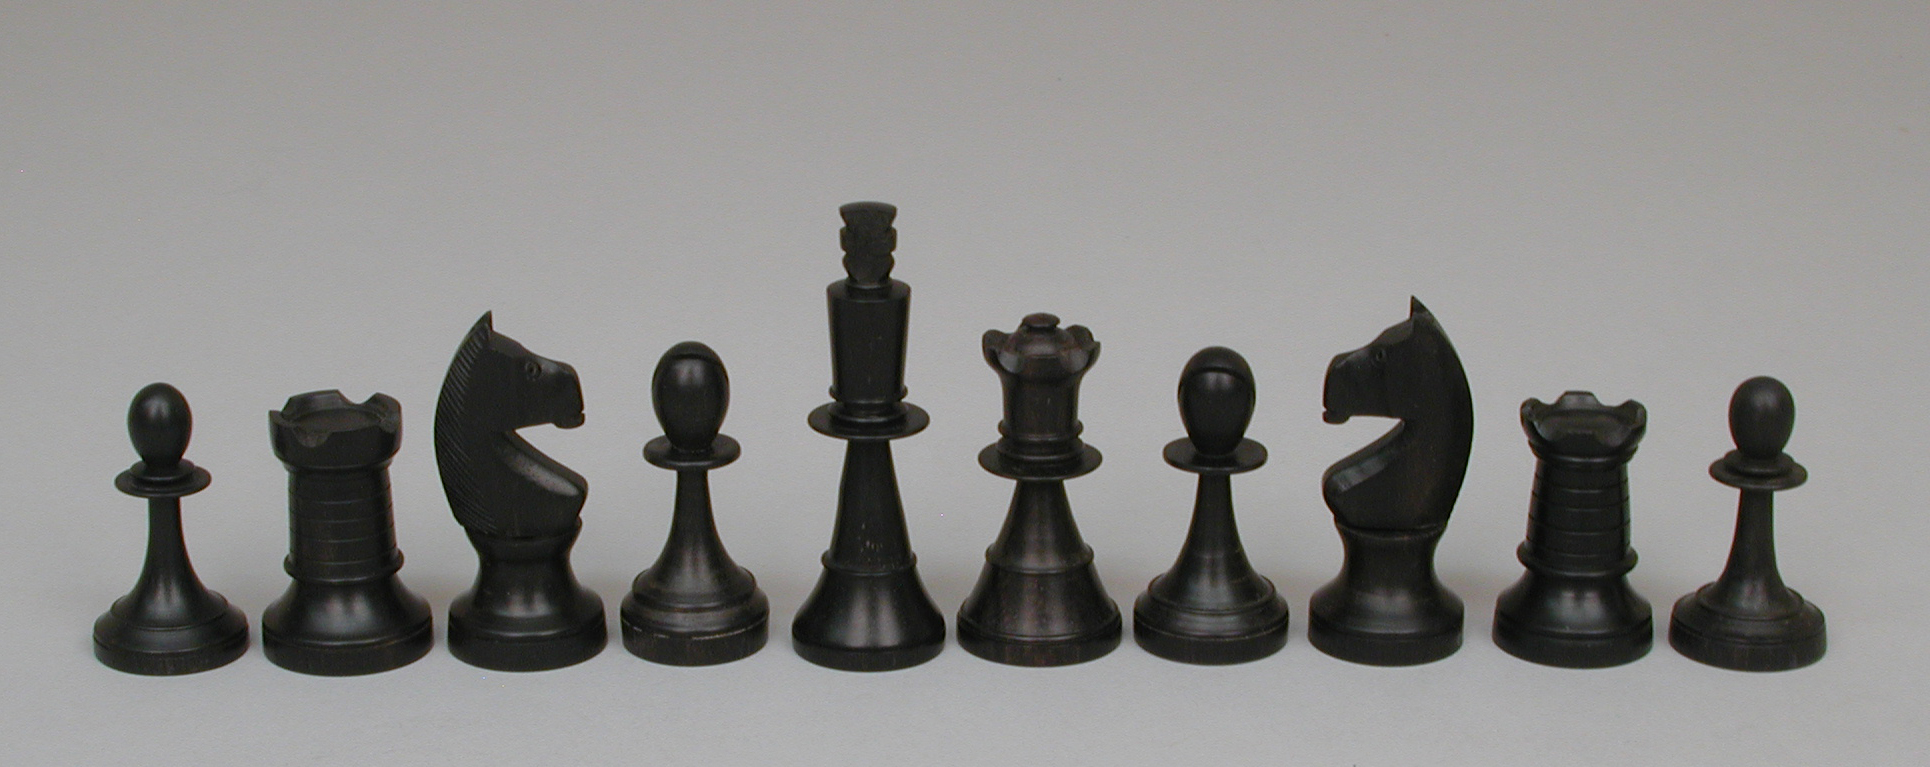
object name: chessman and box board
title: Chessmen (32) and box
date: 1801-1900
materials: wood, ivory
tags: chess,games